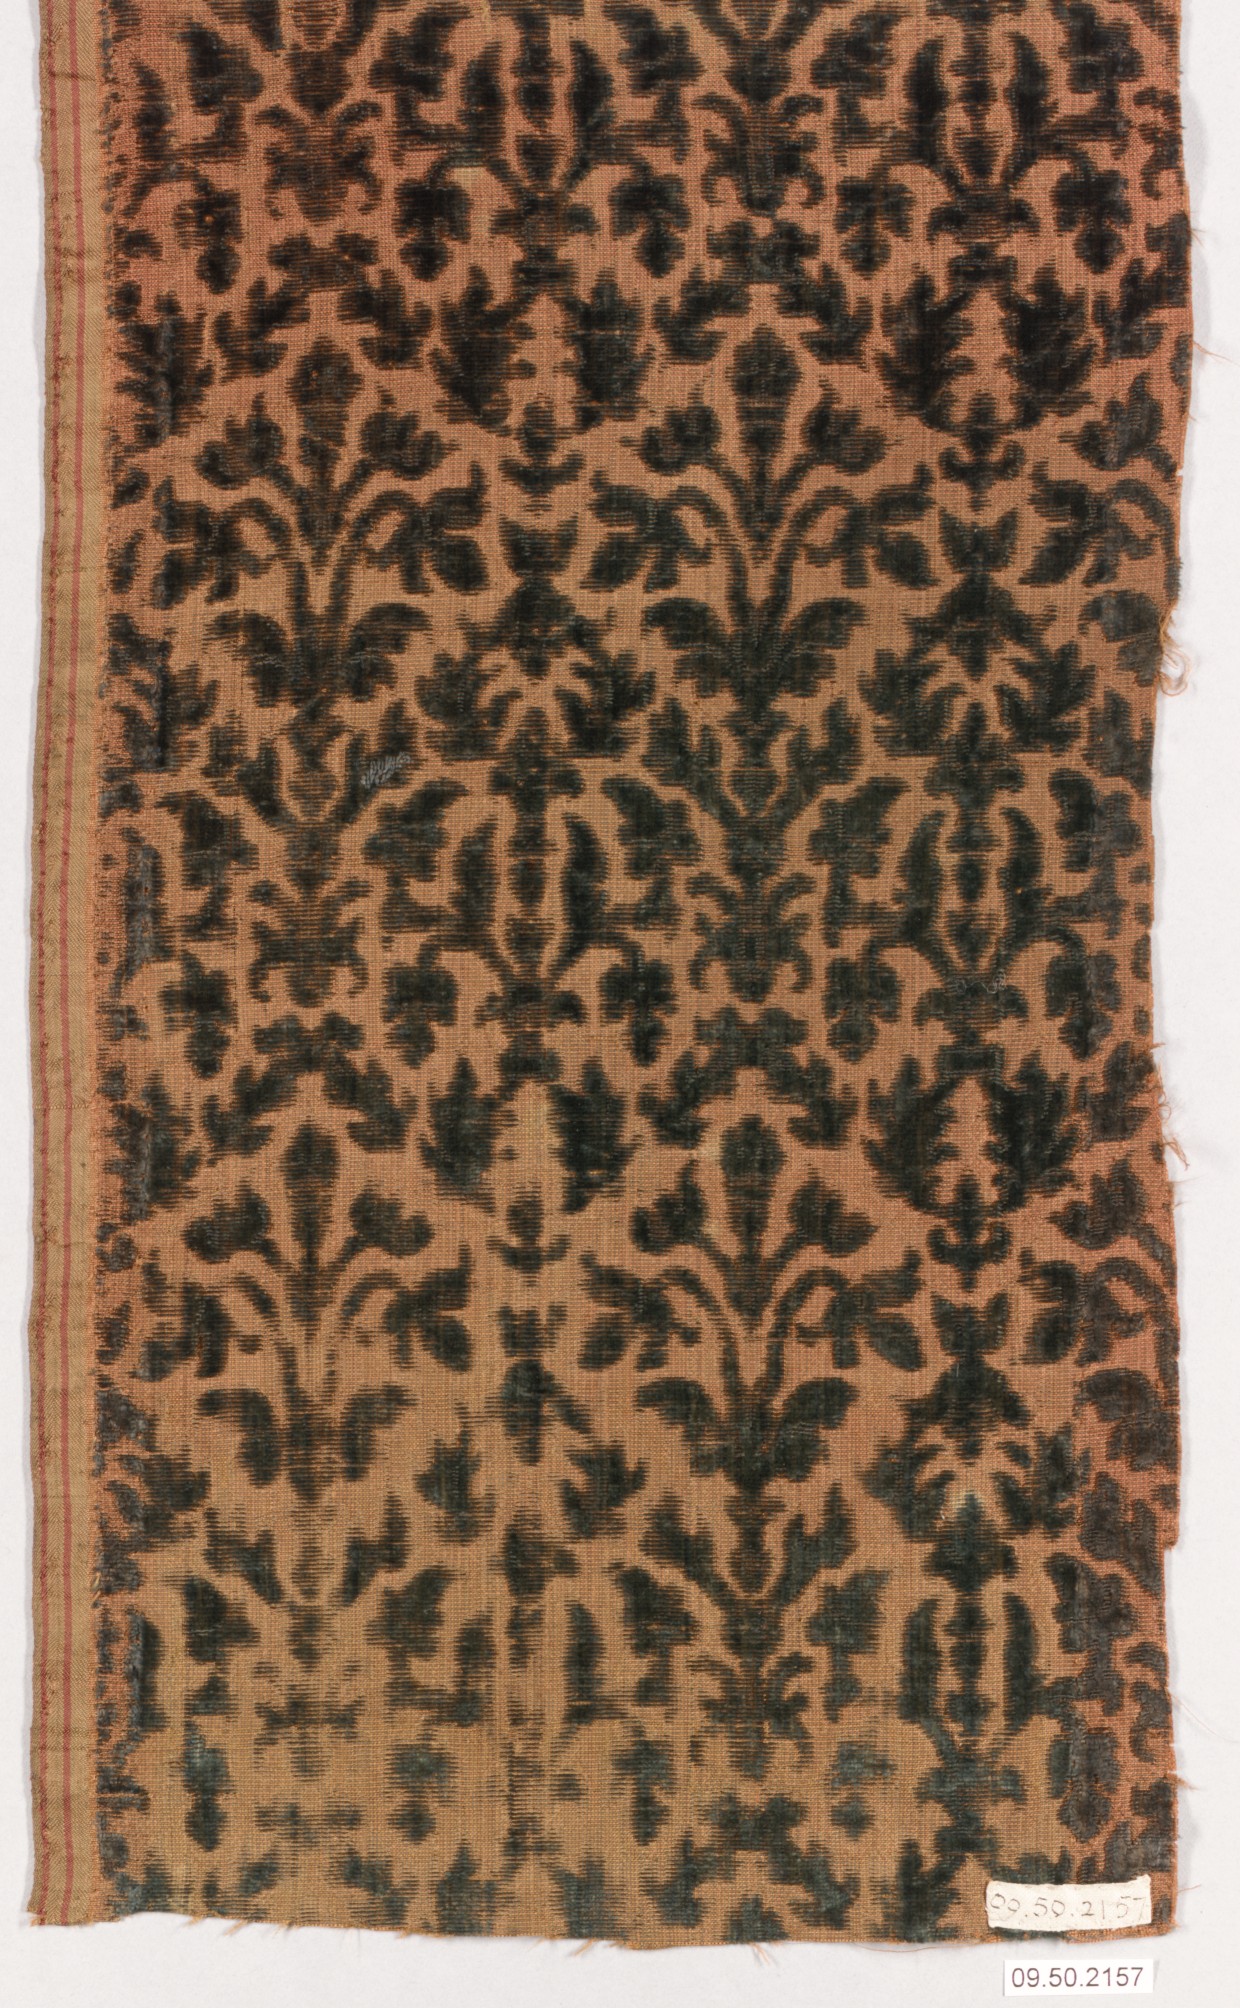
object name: piece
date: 1501-1700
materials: silk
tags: leaves